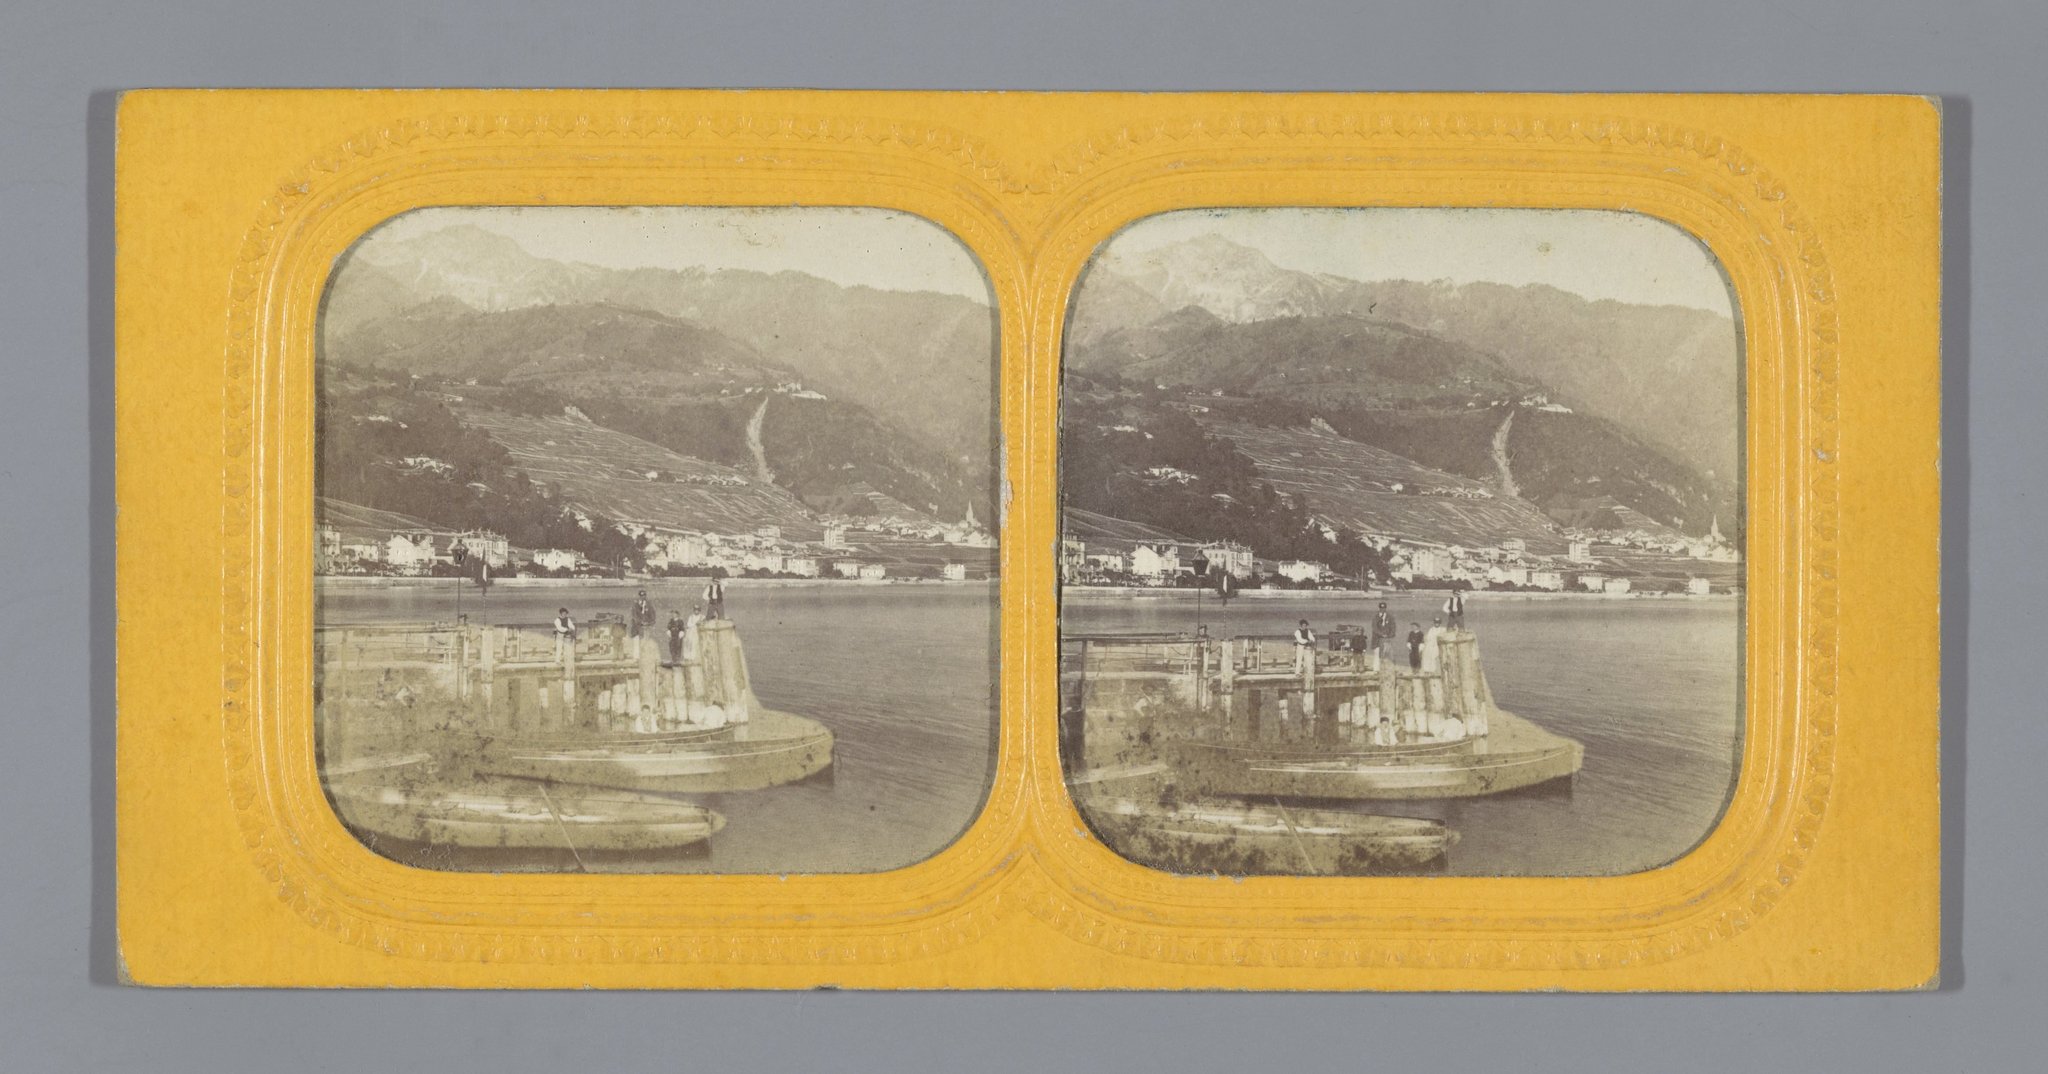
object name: tissue stereograph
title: Montreux, Suisse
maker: Anonymous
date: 1855-1875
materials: cardboard, paper, photographic support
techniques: albumen print, hand coloring, perforating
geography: montreux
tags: lake, city-view in general; 'veduta' (+ city(-scape) with figures, staffage)